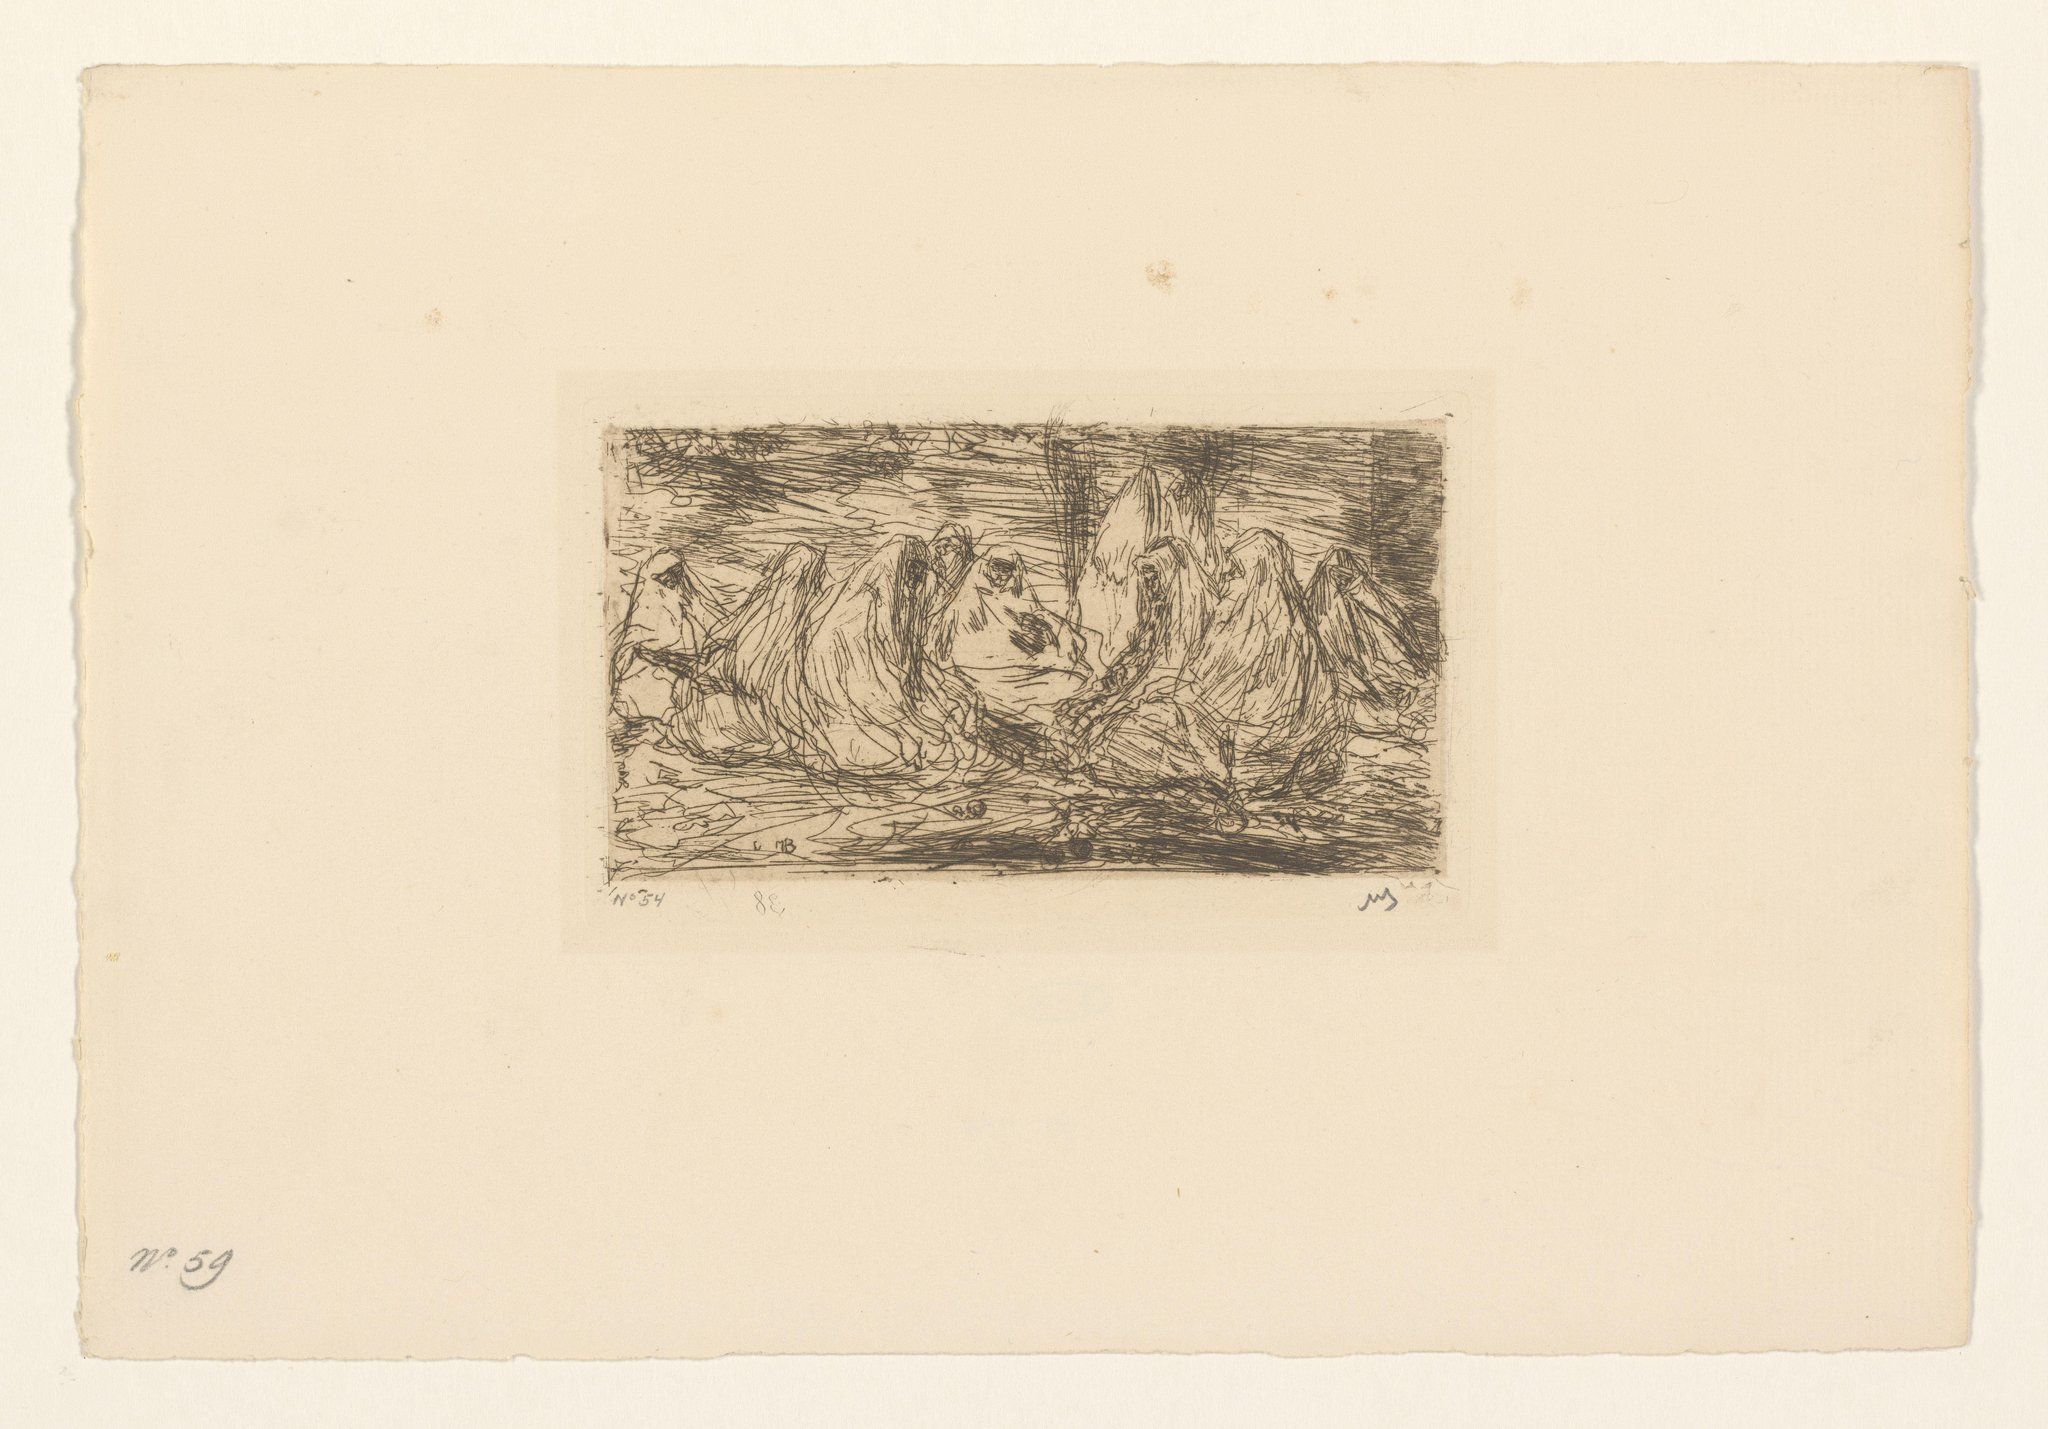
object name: print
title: Zittende, gesluierde vrouwen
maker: marius bauer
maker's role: draughtsman, print maker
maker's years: 1867-1932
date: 1889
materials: paper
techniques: etching, intaglio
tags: veil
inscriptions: collector's mark: Lugt 2760, collector's mark: Lugt 2228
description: Een groep zittende, gesluierde vrouwen. Onderaan is het nummer 38 in spiegelbeeld gedrukt.